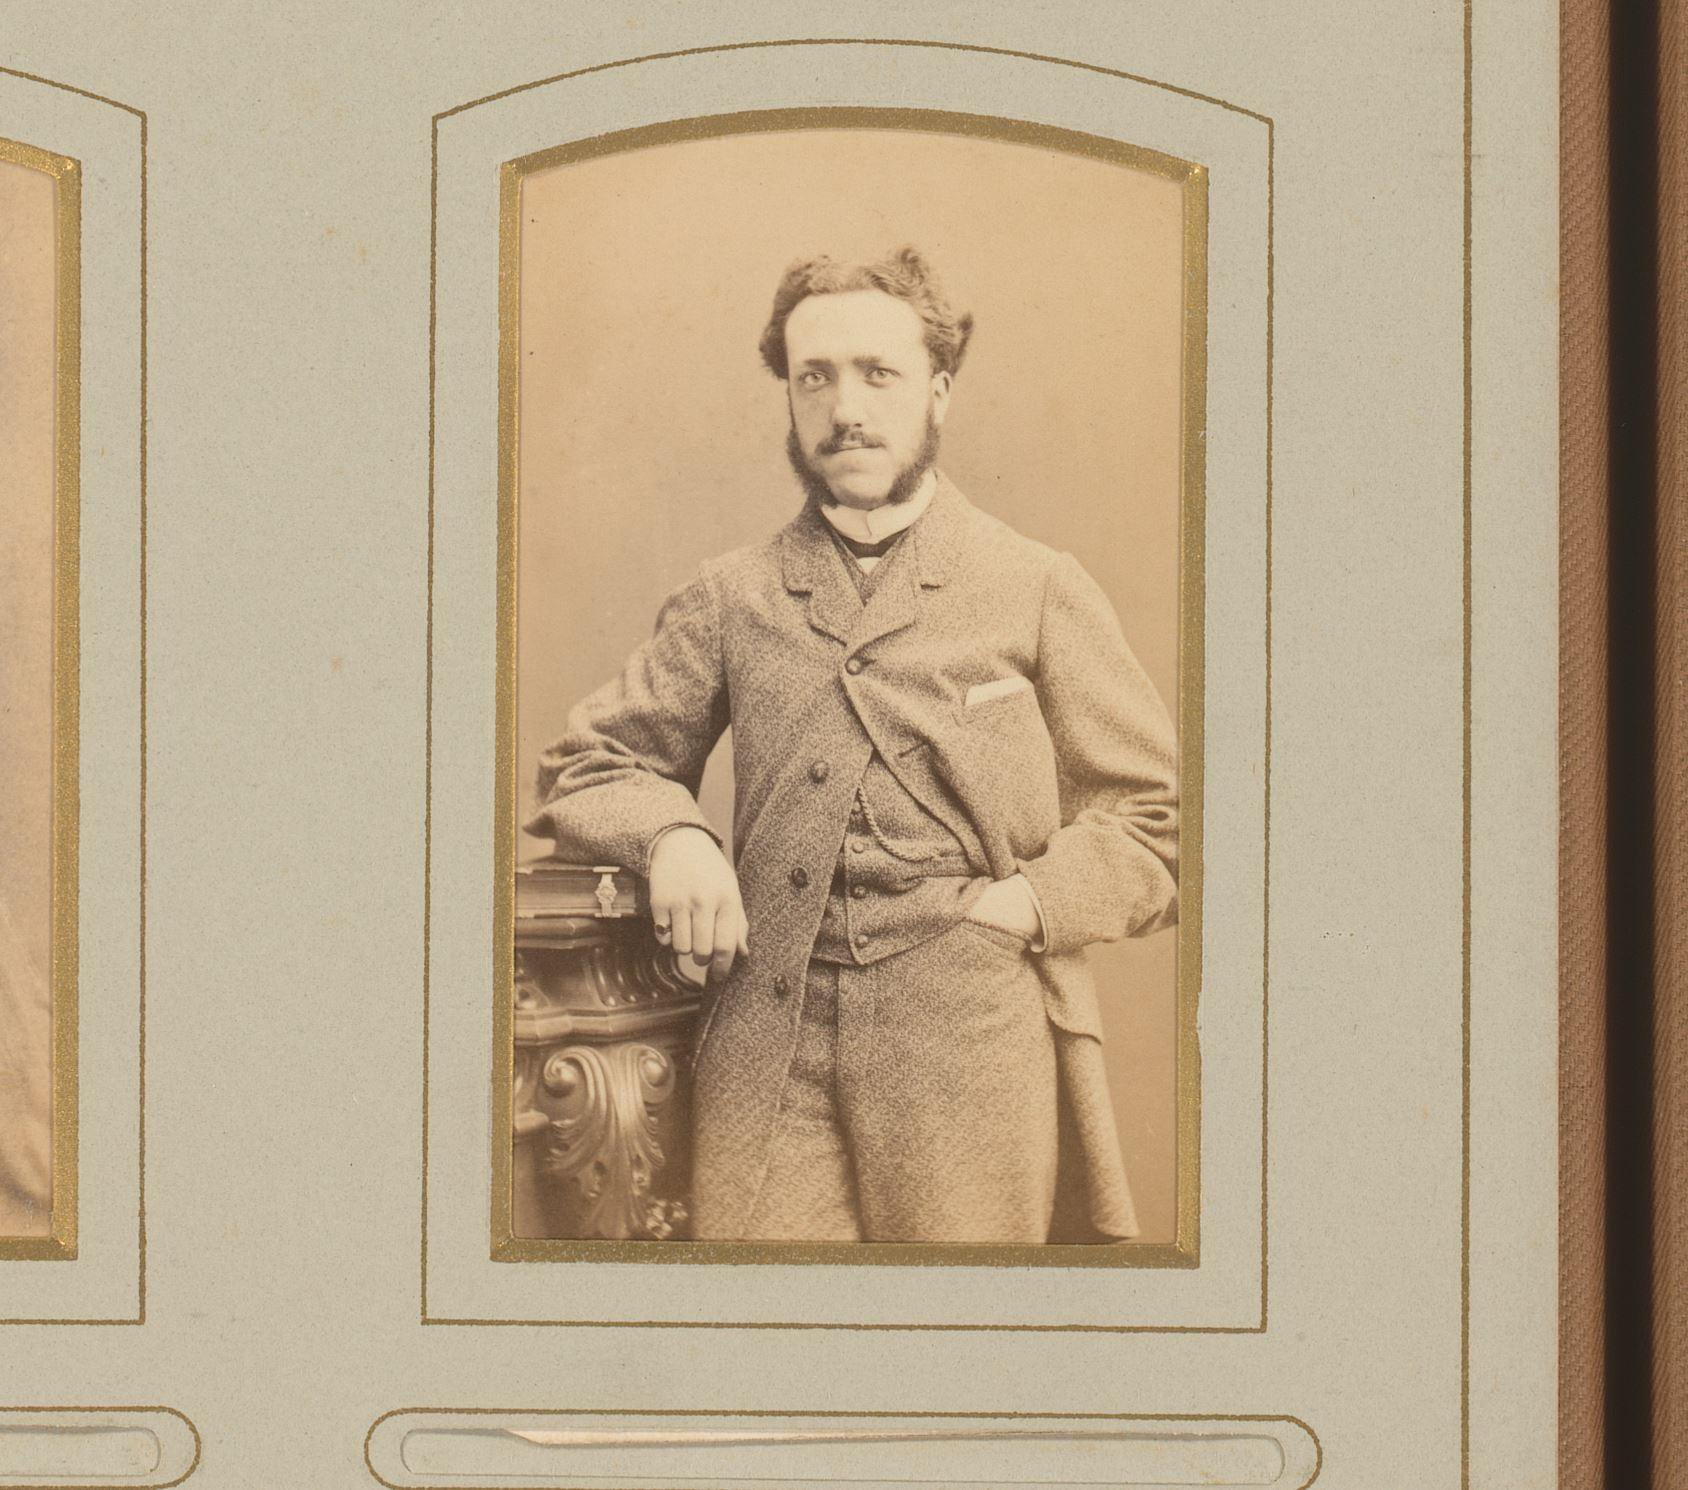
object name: album leaf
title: Portret van een staande man, leunend op een balustrade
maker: louis désiré dupont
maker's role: fotograaf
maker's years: 1825-1878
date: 1864-1901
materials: cardboard, photographic support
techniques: albumen print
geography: brussels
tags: standing figure, historical persons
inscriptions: inscription: ‘PHOTOGRAPHIE INSTANTANÉE/ Mr & Me DUPONT/ PHOTOGRAPHES/ 67, Rue Neuve 67./ BRUXELLES/ Atelier de pose au premier./ Les Clichés étant toujours indéfiniment/ on peut toujours se procurer de nouvelles/ épreuves de Cartes & Portraits sans reposer’